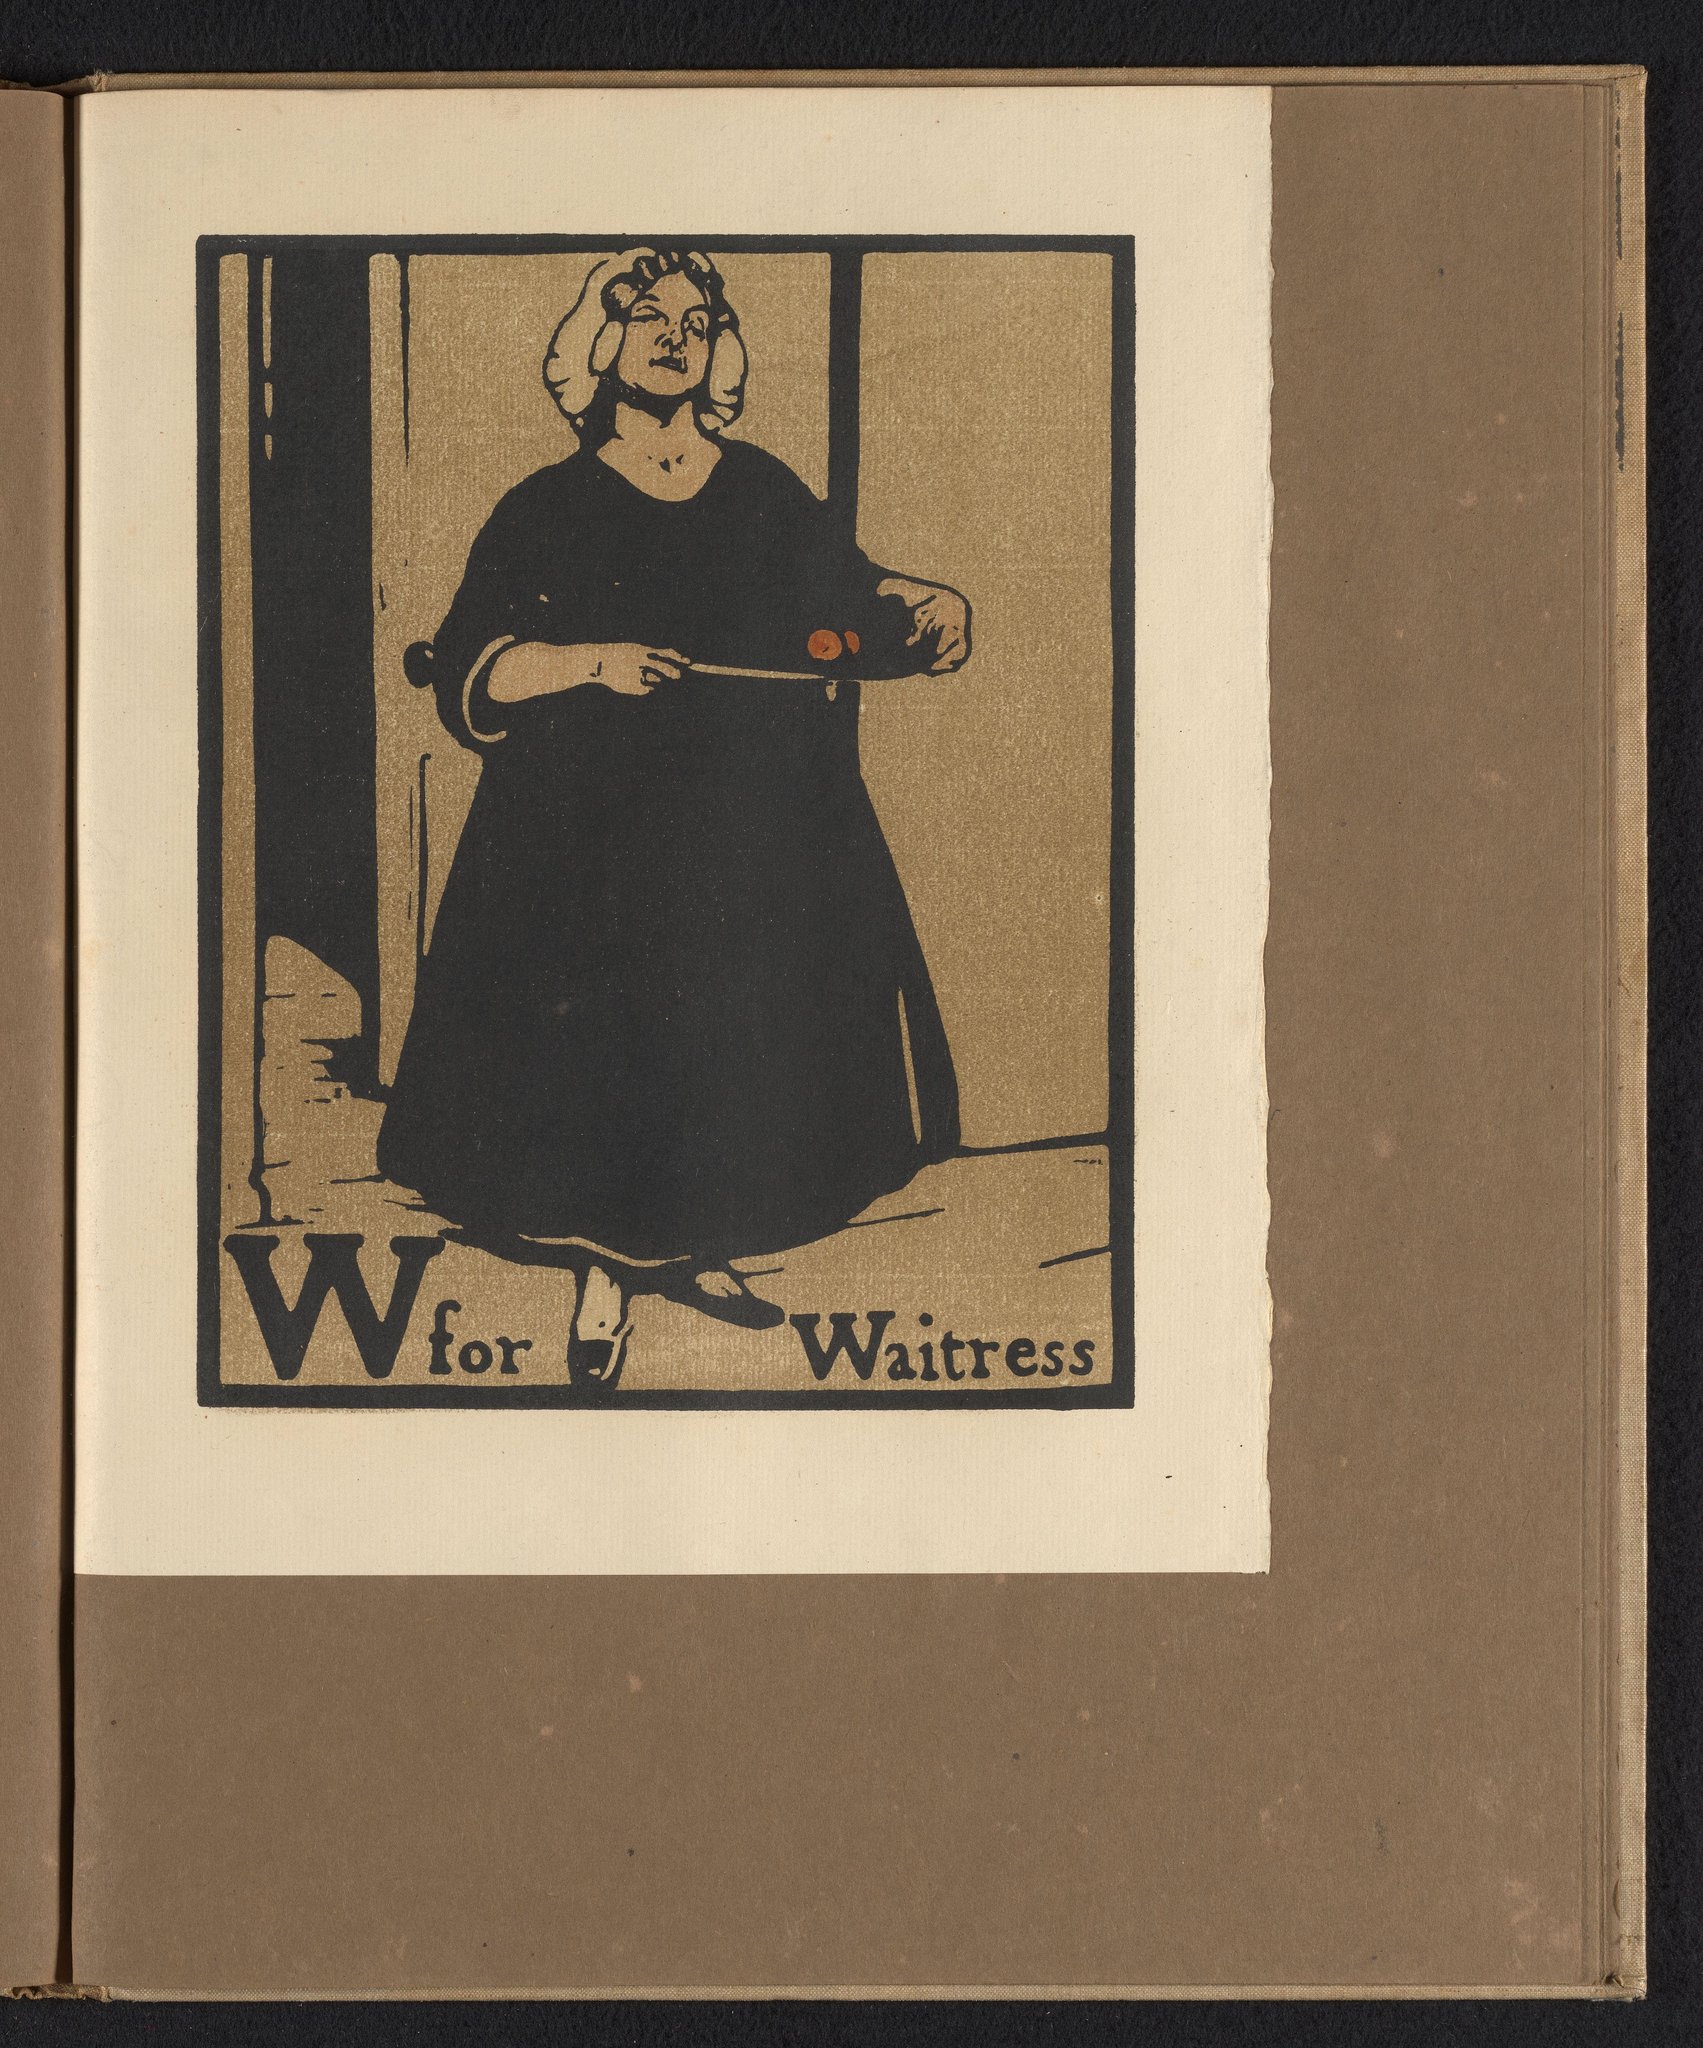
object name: page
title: Alfabet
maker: william heinemann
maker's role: publisher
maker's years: 1863-1920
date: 1898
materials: paper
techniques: lithograph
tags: adult woman, kitchen-personnel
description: De serie met lithografieën is gemaakt naar ontwerpen van houtsneden door William Nicholson.